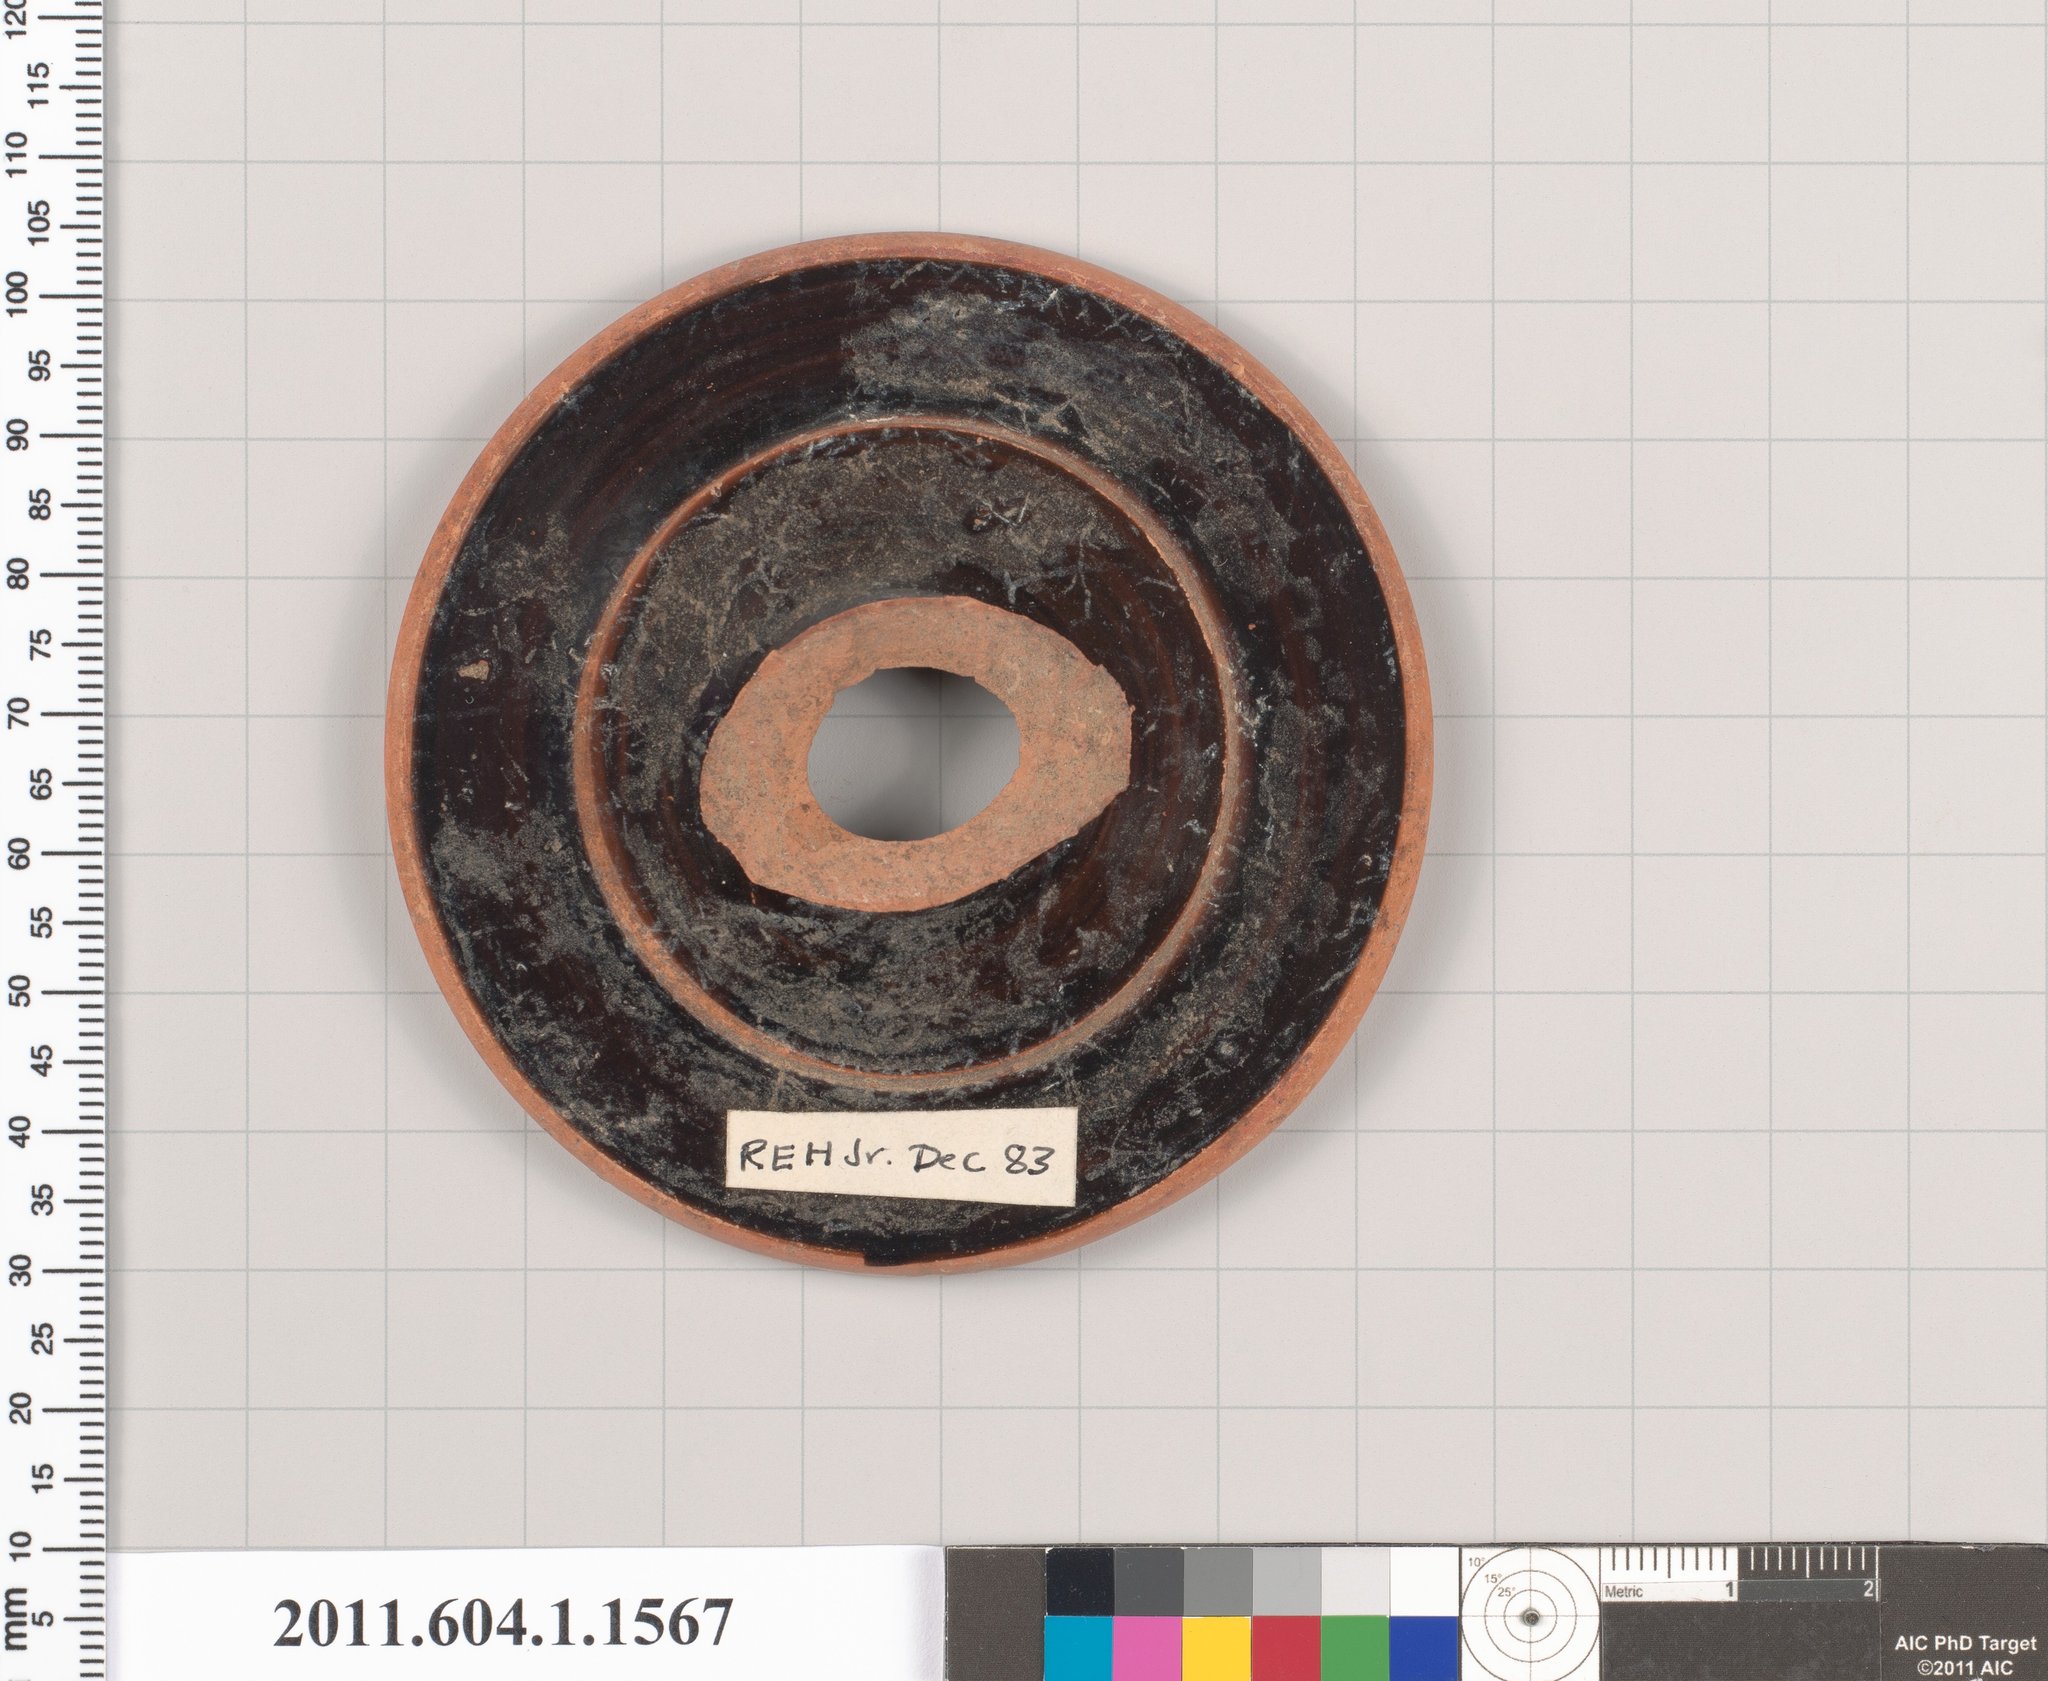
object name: kylix fragment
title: Terracotta fragment of a kylix (drinking cup)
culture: greek, attic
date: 500-401 BCE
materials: terracotta